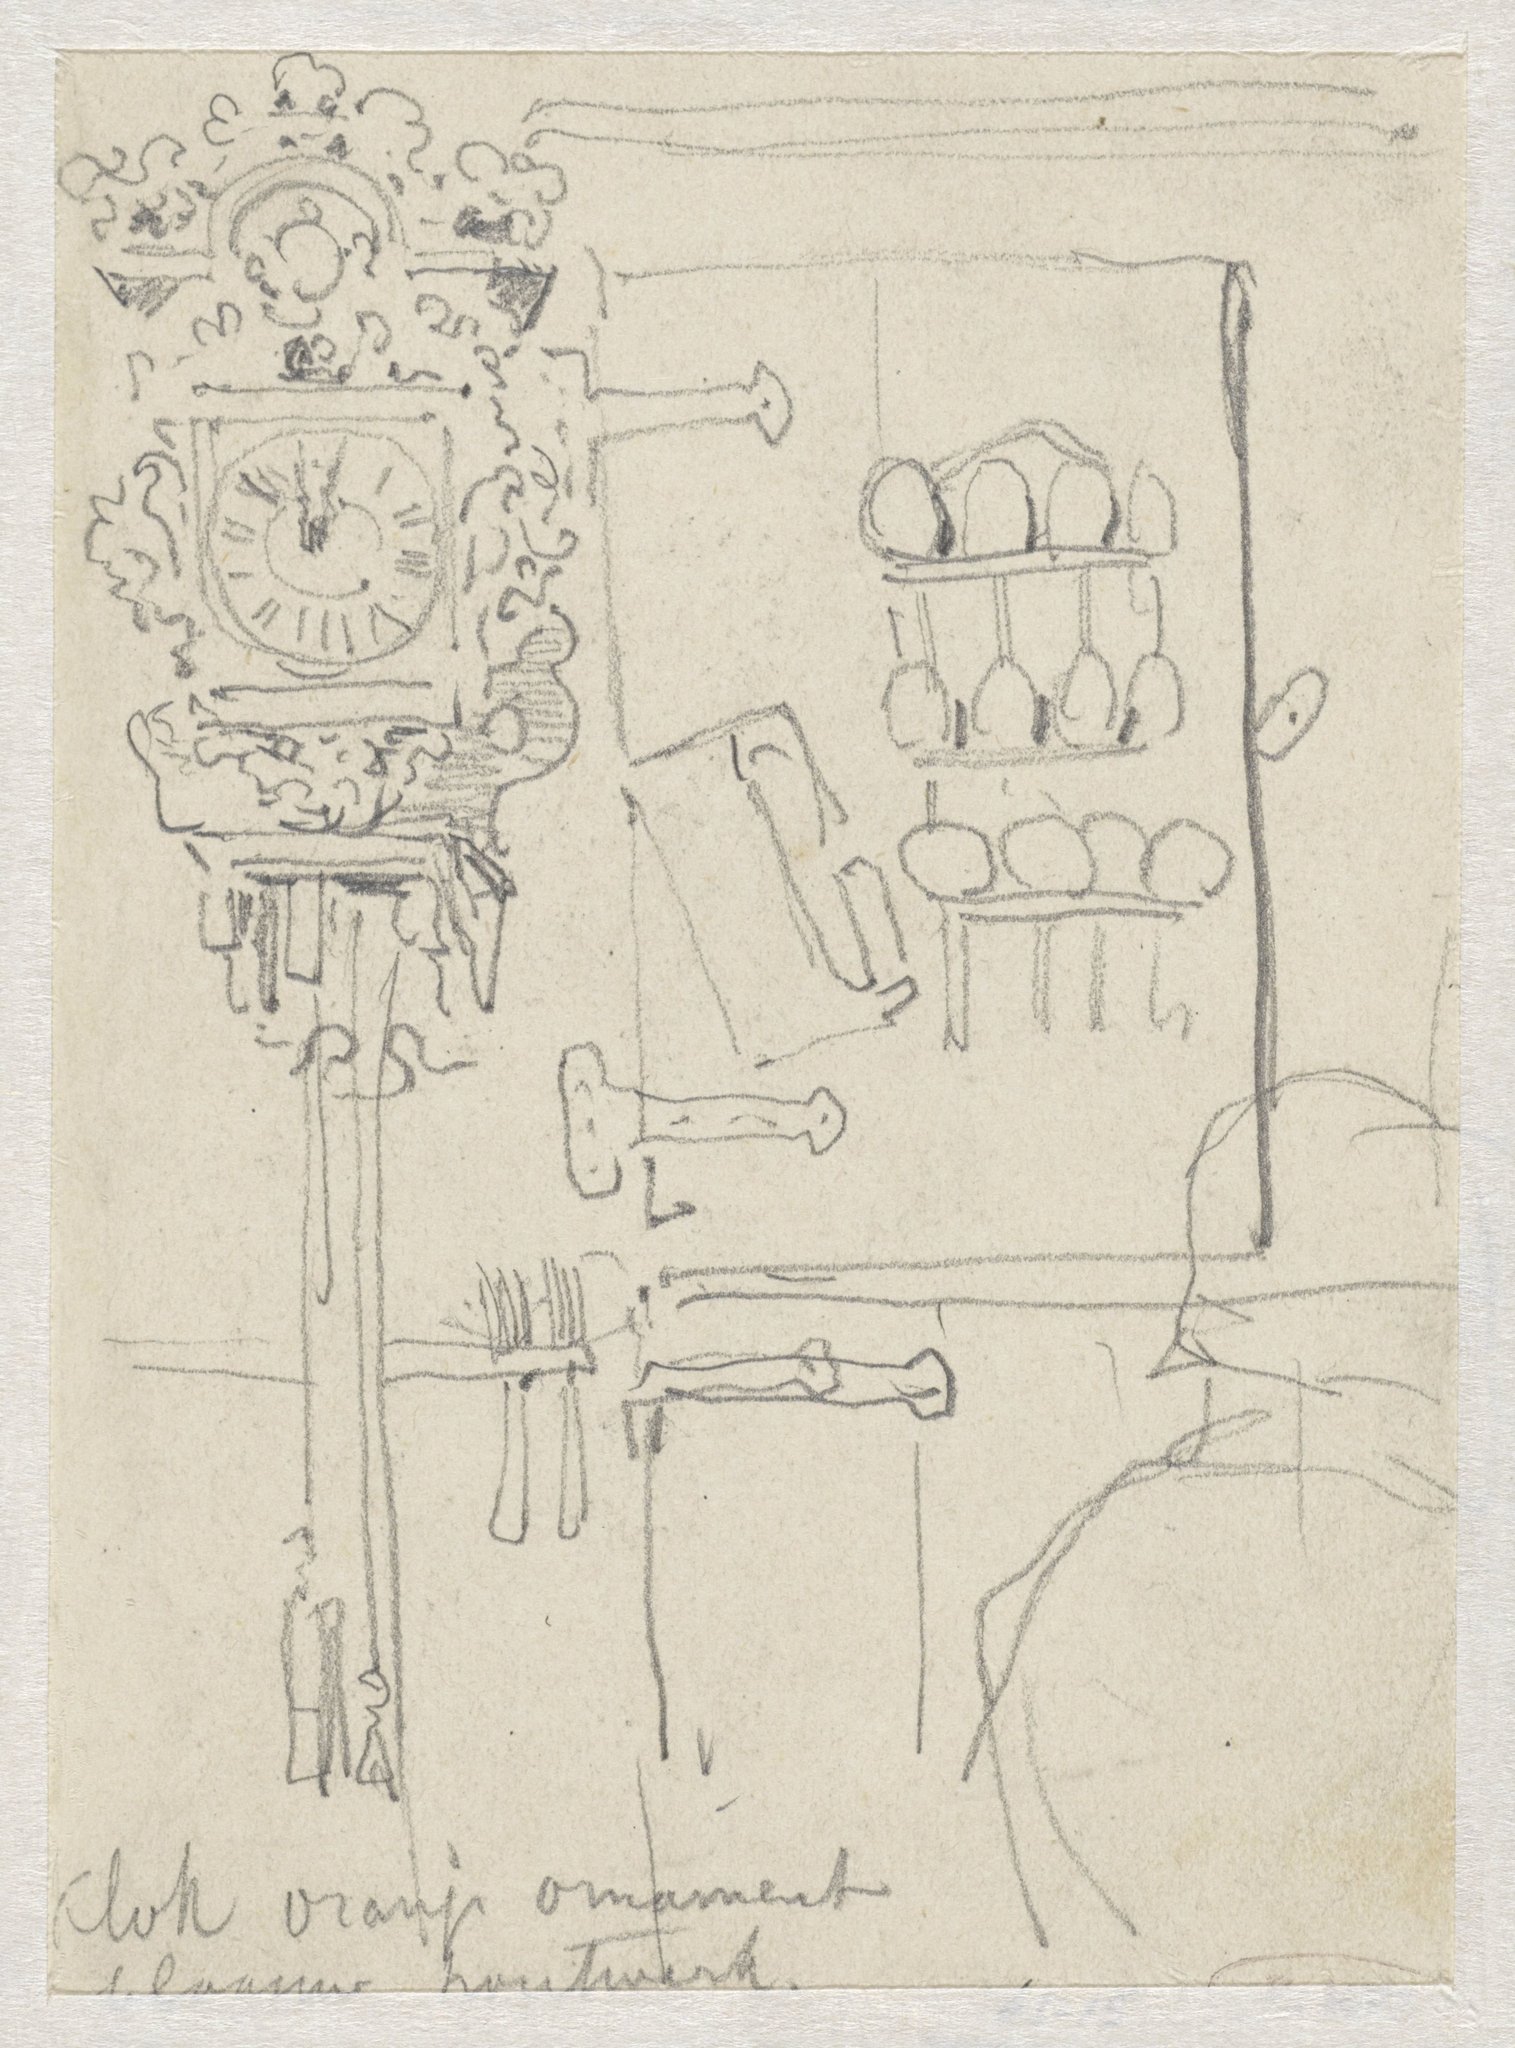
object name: drawing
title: Stoeltjesklok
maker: adolf le comte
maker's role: draughtsman, painter, print maker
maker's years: 1850-1921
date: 1860-1921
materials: paper, pencil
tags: clock